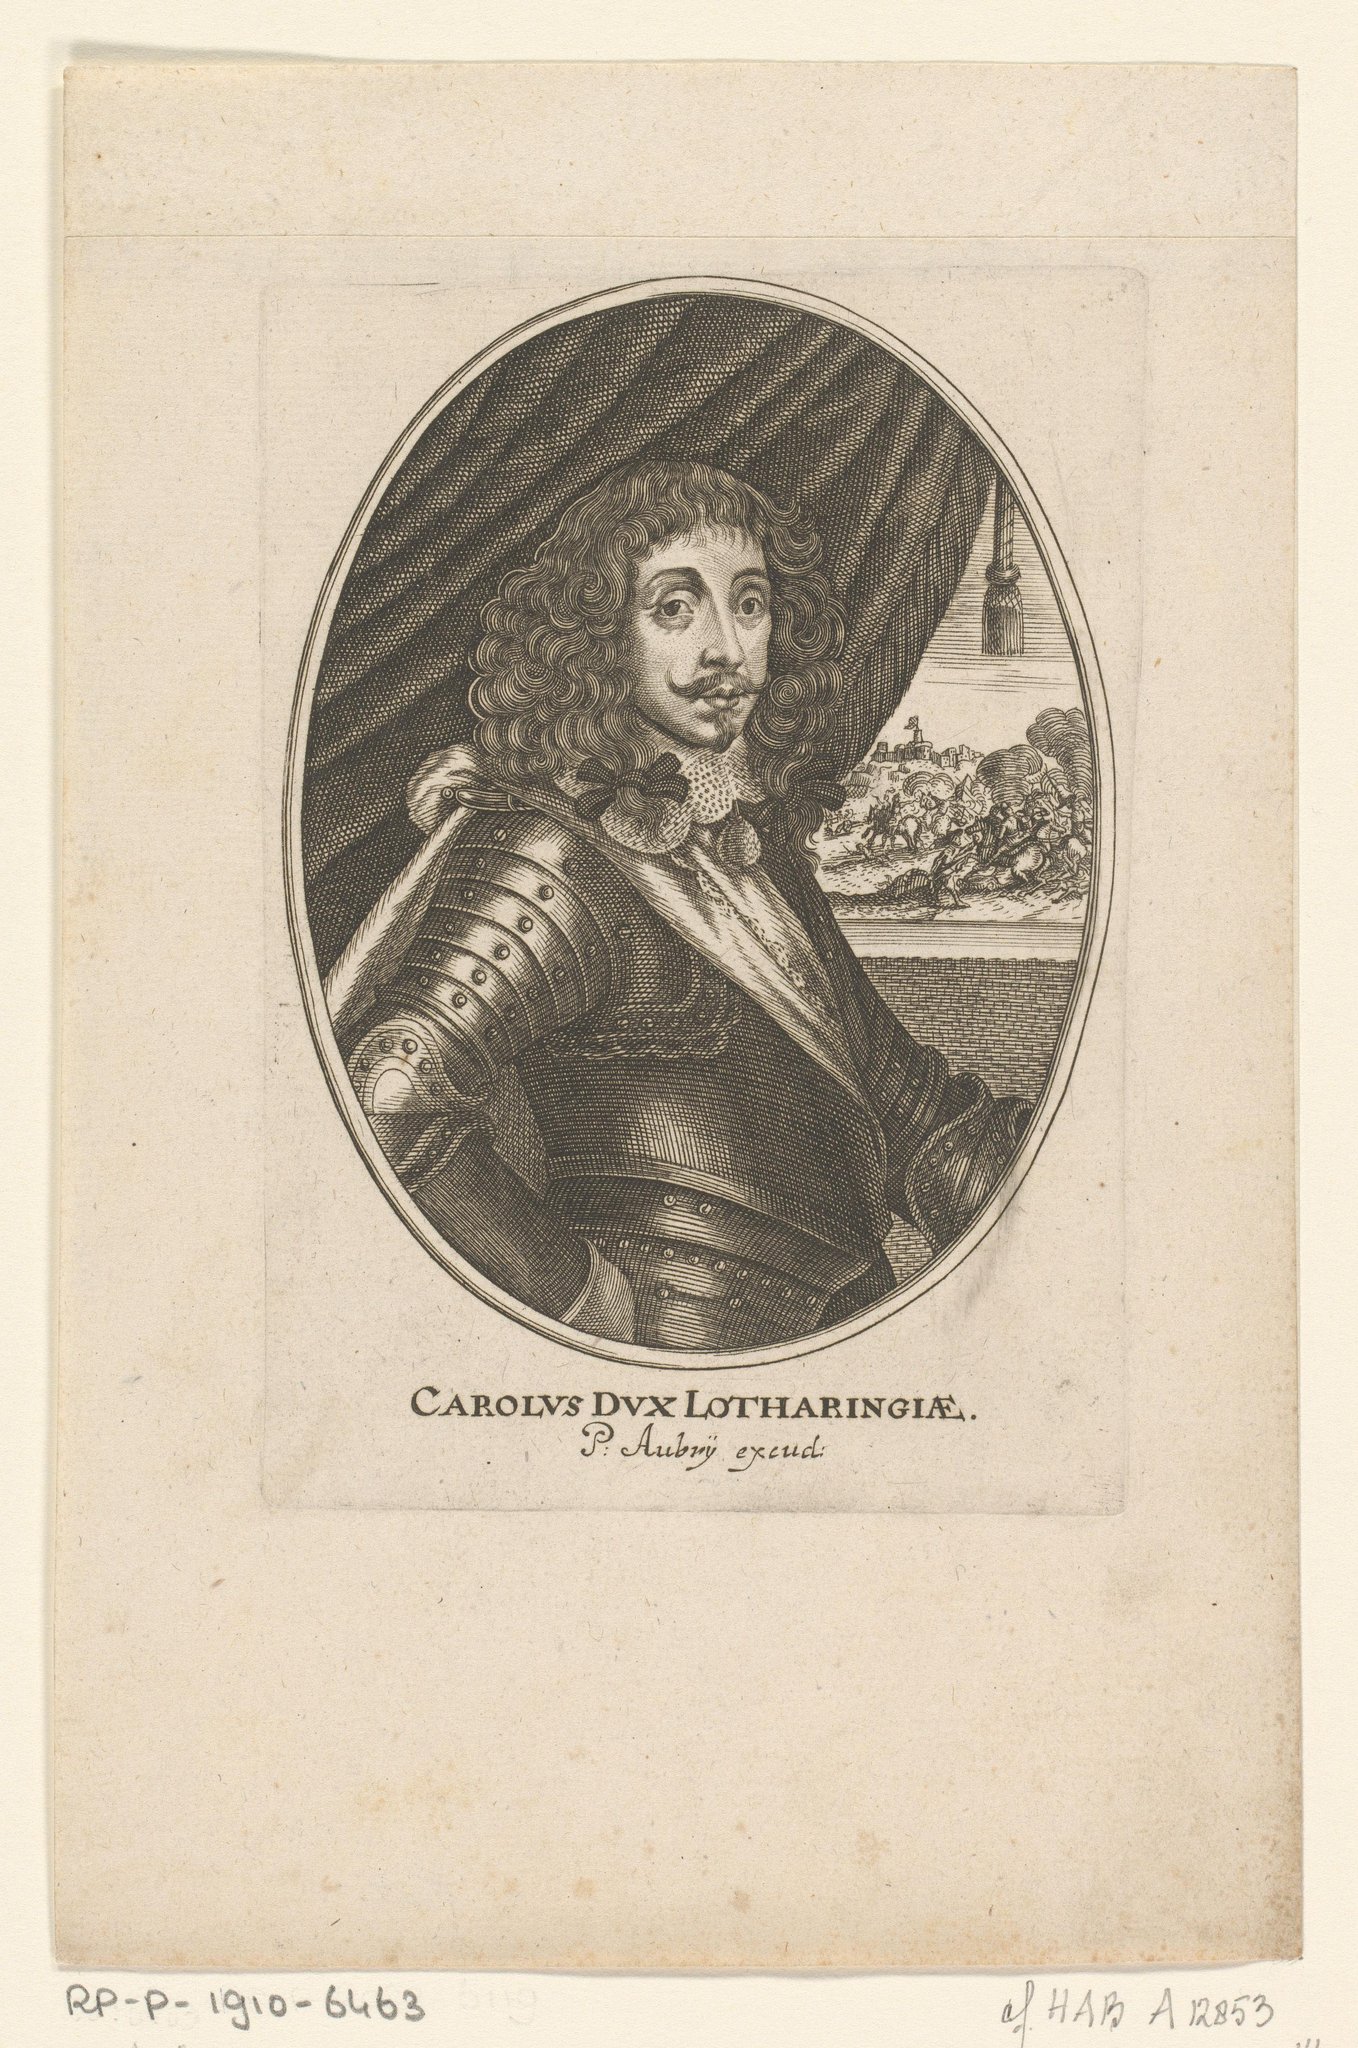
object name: print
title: Portret van Karel IV van Lotharingen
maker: Anonymous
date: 1625-1686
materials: paper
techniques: engraving, etching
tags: karel iv hertog van lotharingen, historical persons, other sovereign (with title)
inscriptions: collector's mark: Lugt 2228